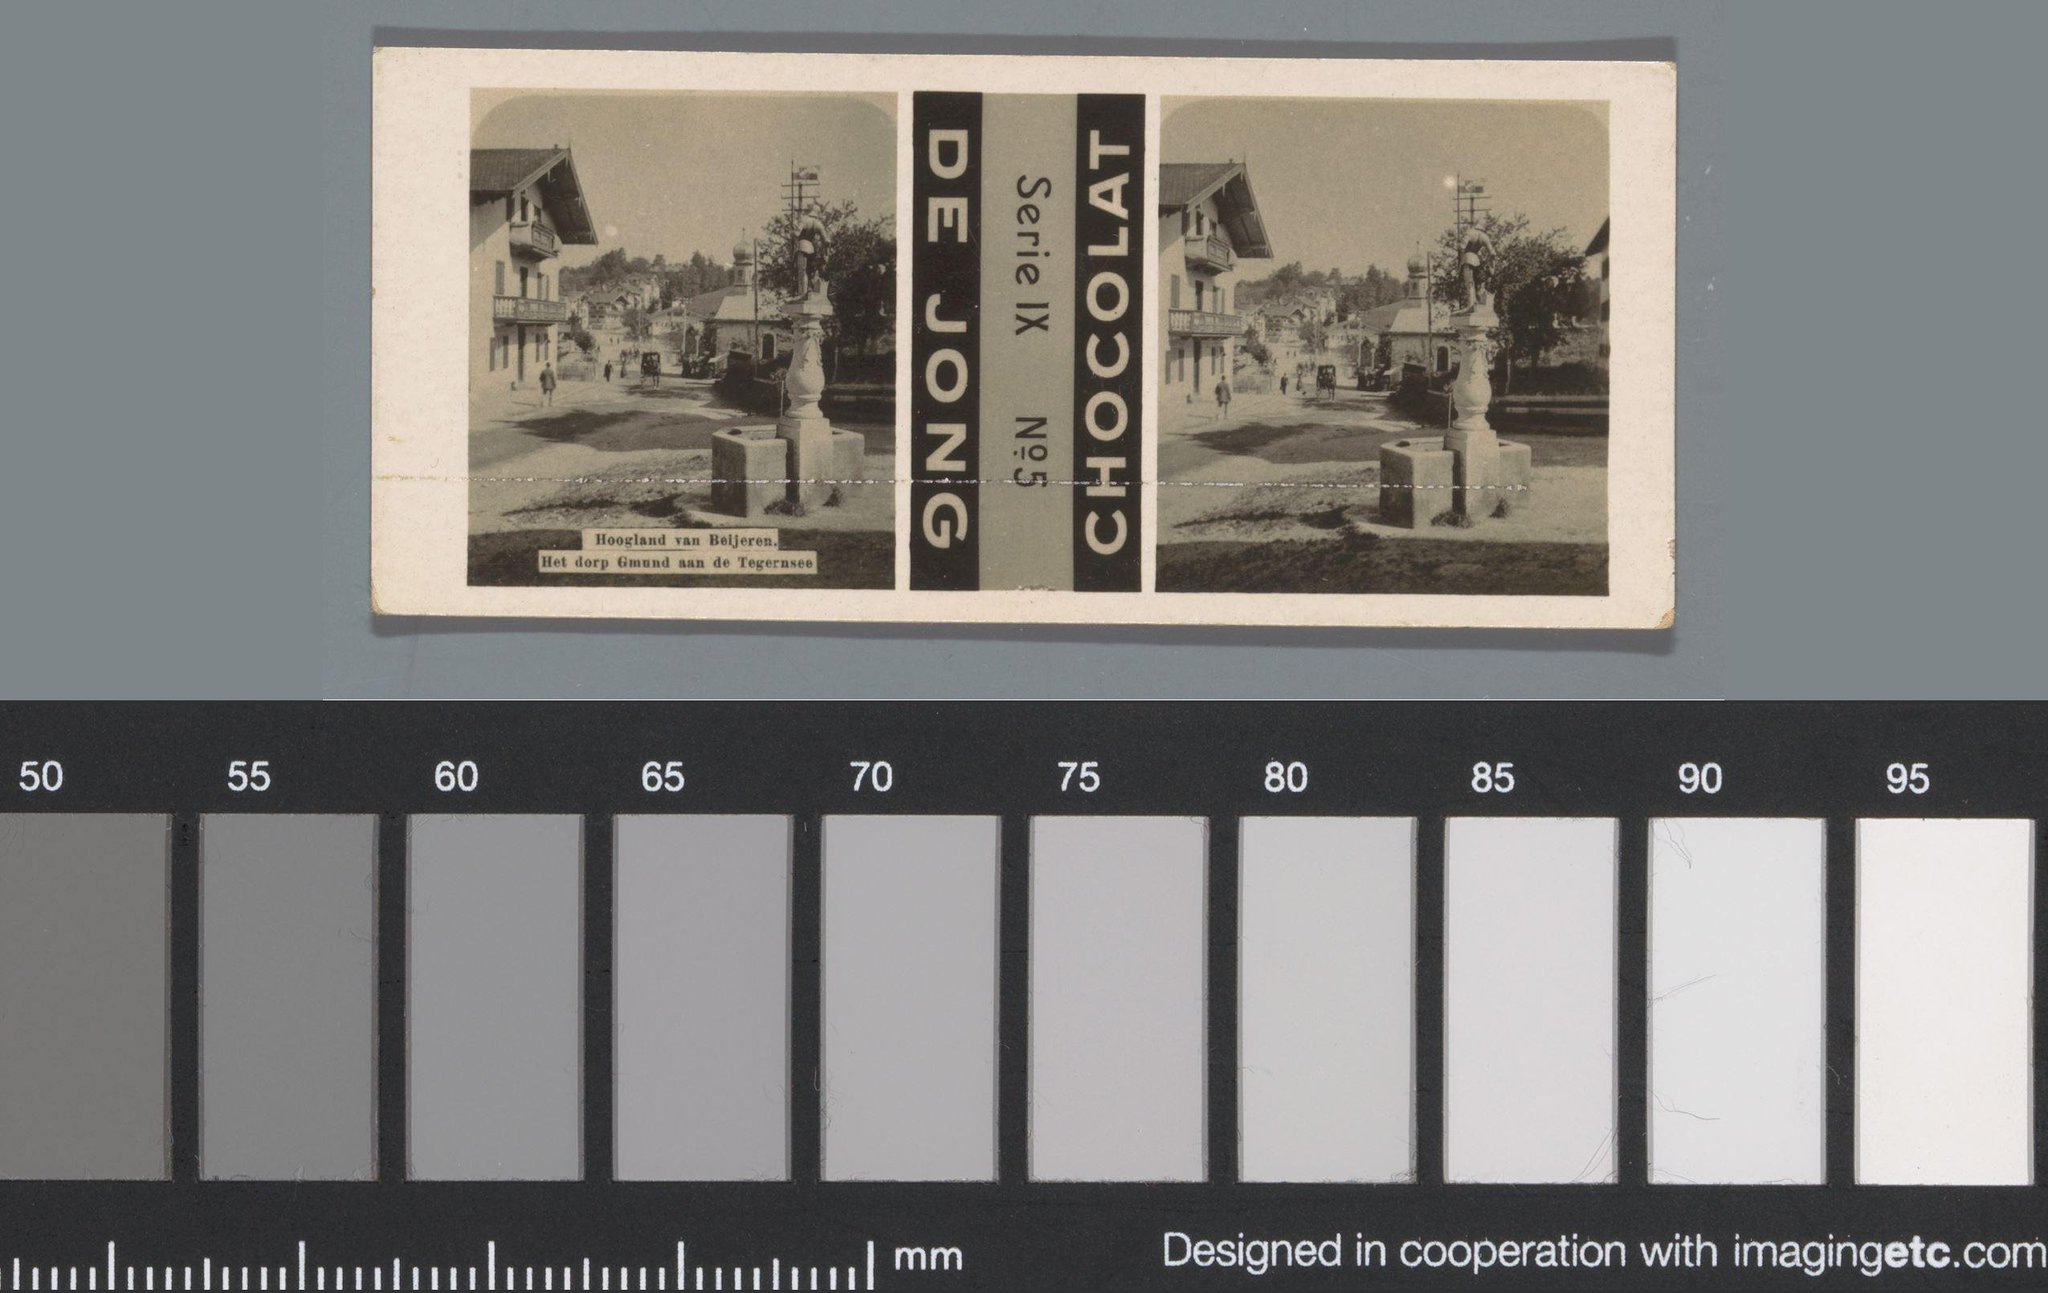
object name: stereograph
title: Plein te Gmund am Tegernsee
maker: Anonymous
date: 1900-1910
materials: cardboard, photographic support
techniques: gelatin silver print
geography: wormerveer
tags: street, village square, place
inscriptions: number: ‘Serie IX No 5’, inscription: ‘De Jong Chocolat’